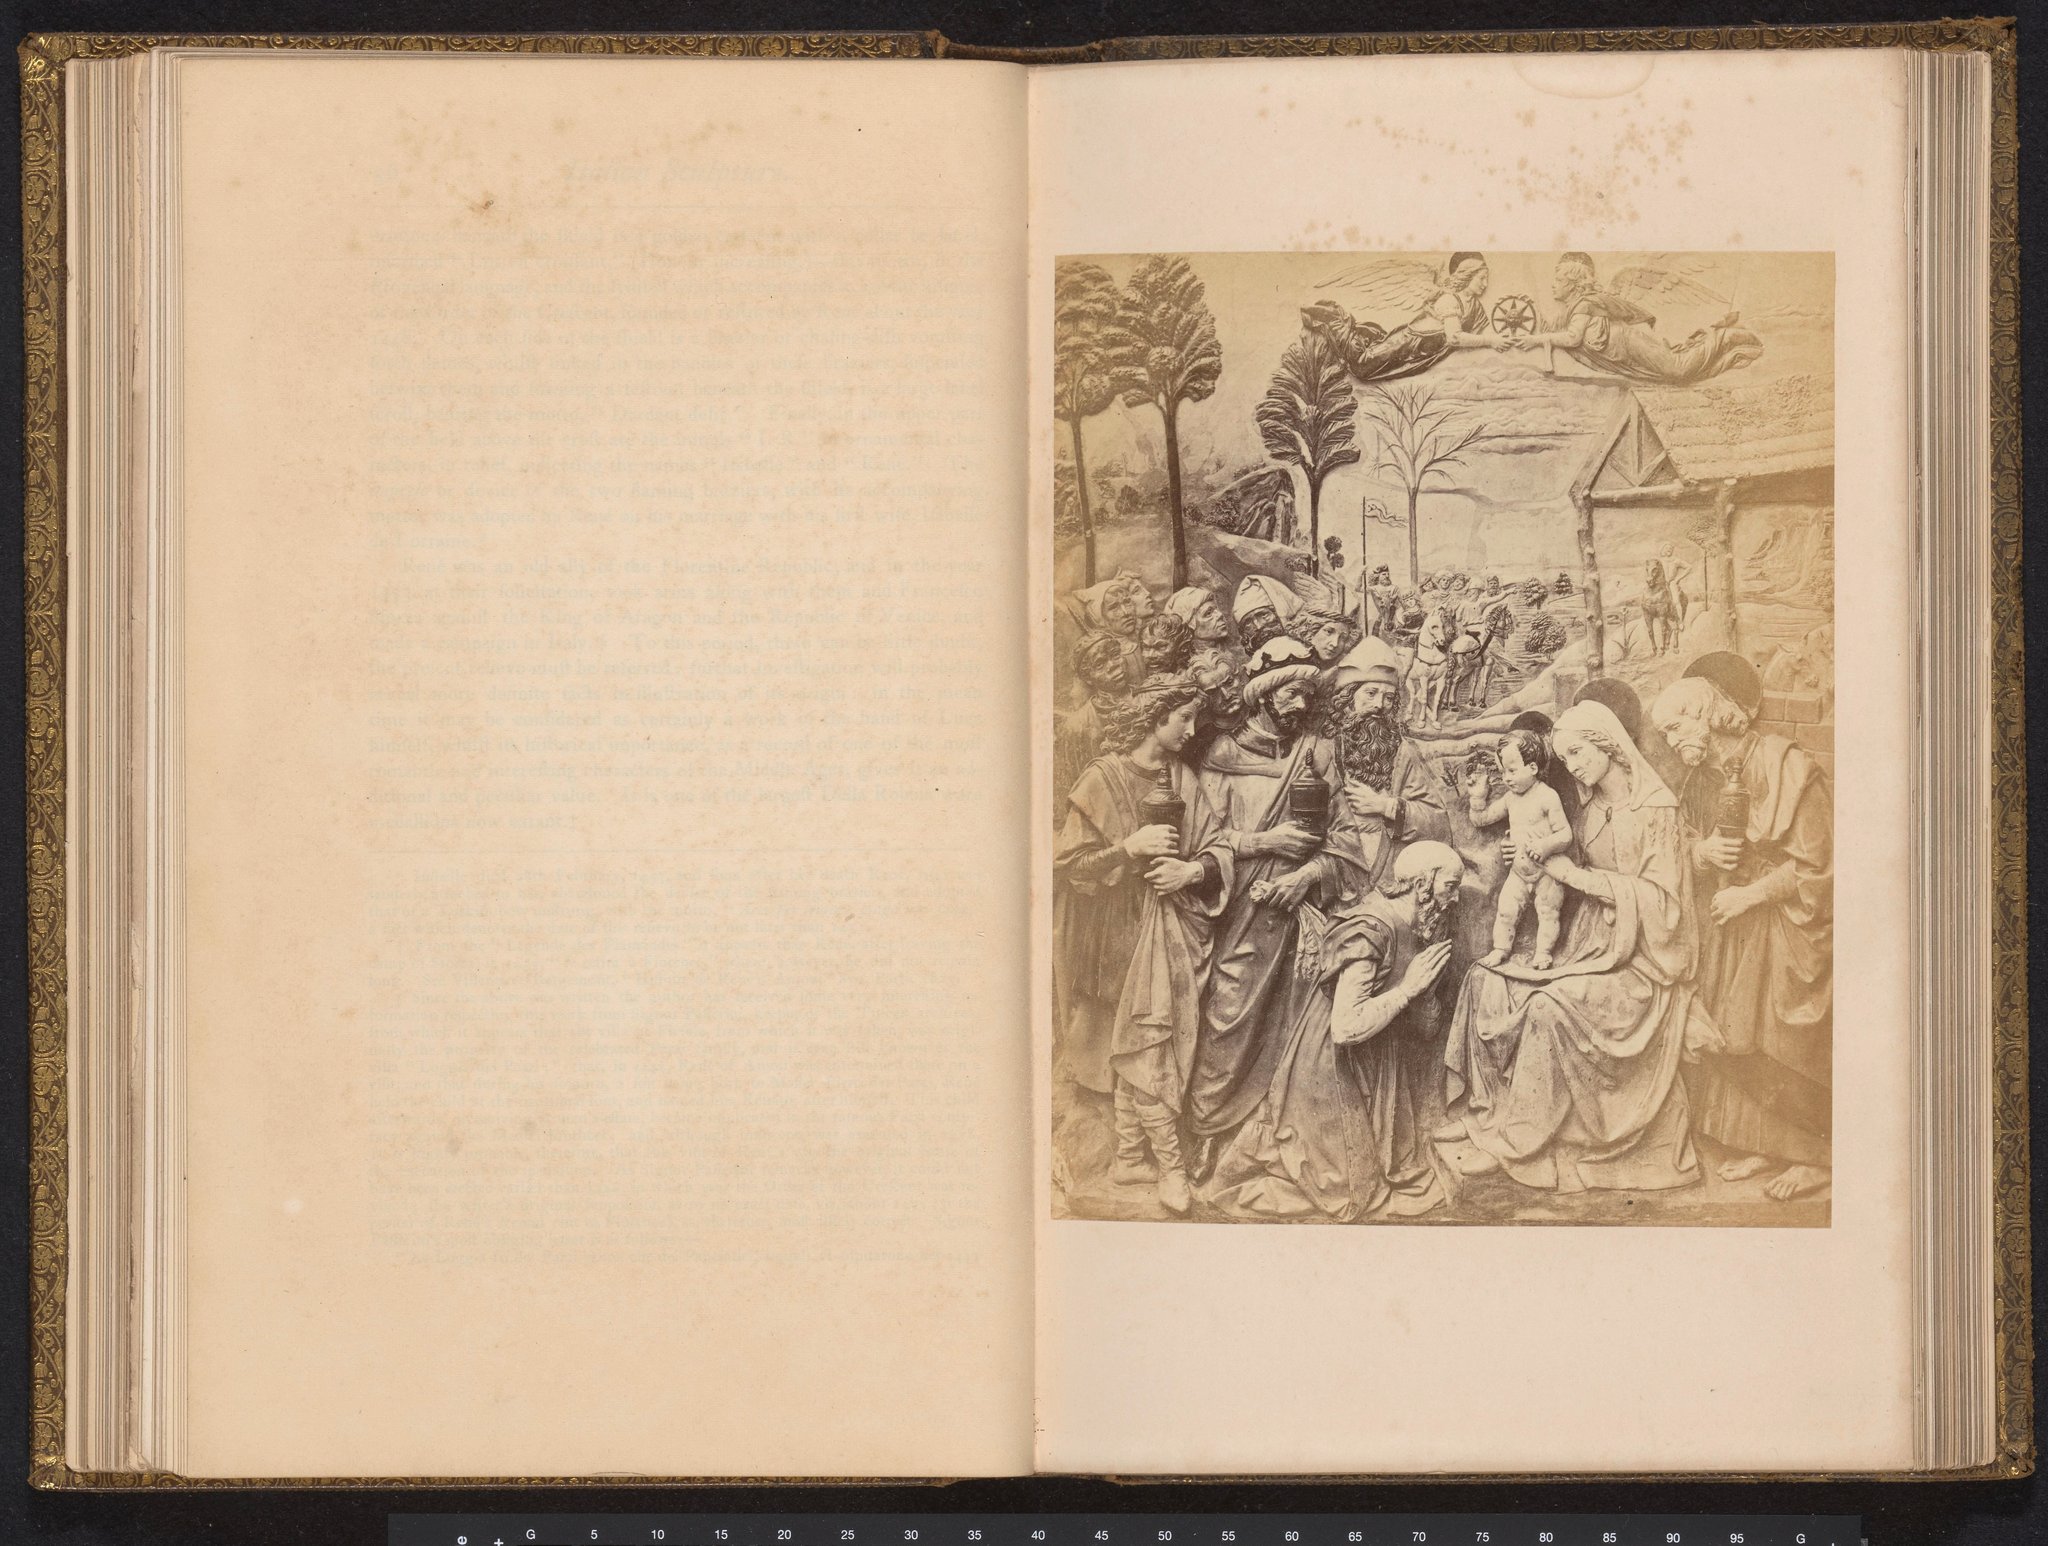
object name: page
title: Reliëf met de Aanbidding der Koningen door Andrea Della Robbia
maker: Anonymous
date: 1852-1862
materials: photographic support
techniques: albumen print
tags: adoration of the christ-child ~ christ's birth, sculpture (+ relief ~ sculpture)